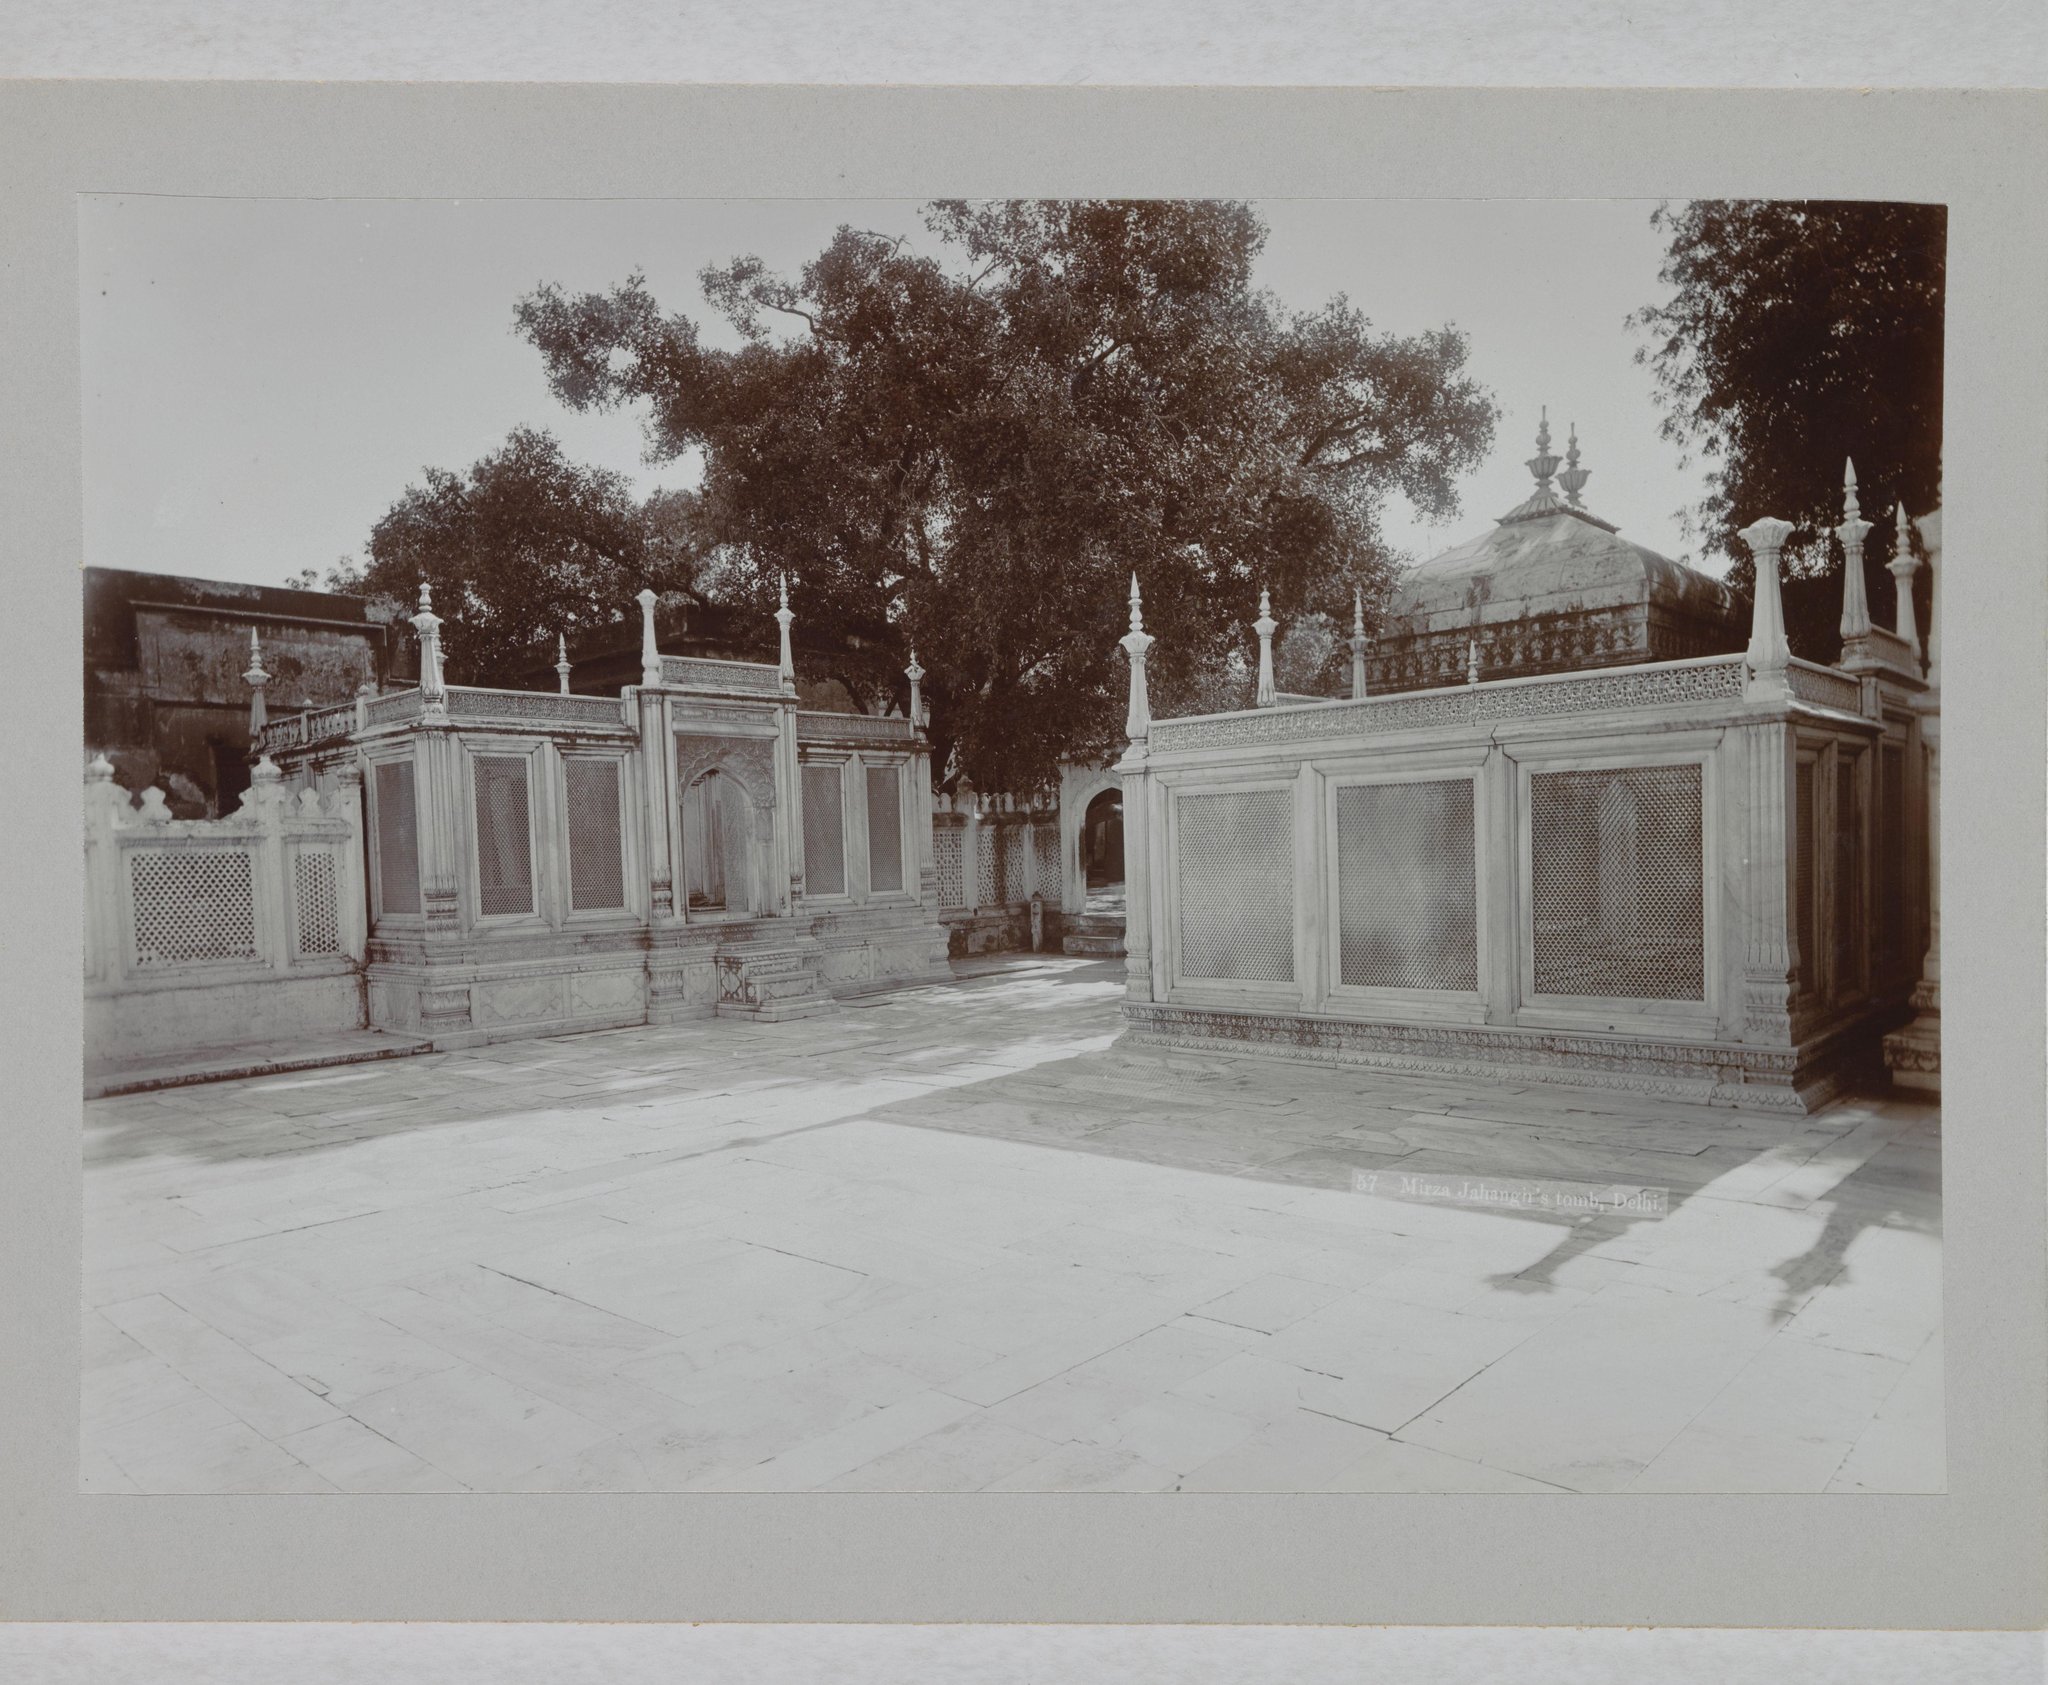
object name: photograph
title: Mirza Jahangir's Tomb, Delhi, India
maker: Anonymous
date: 1895-1915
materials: cardboard, paper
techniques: gelatin silver print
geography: delhi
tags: delhi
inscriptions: inscription: ‘57 Mirza Jahangir's tomb, Delhi’, annotation: ‘38. Graven in eene der oude Delhi's.’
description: Het graf van Mirza Jahangir bevindt zich in het complex van Hazrat Nizamuddin Auliya te Delhi.